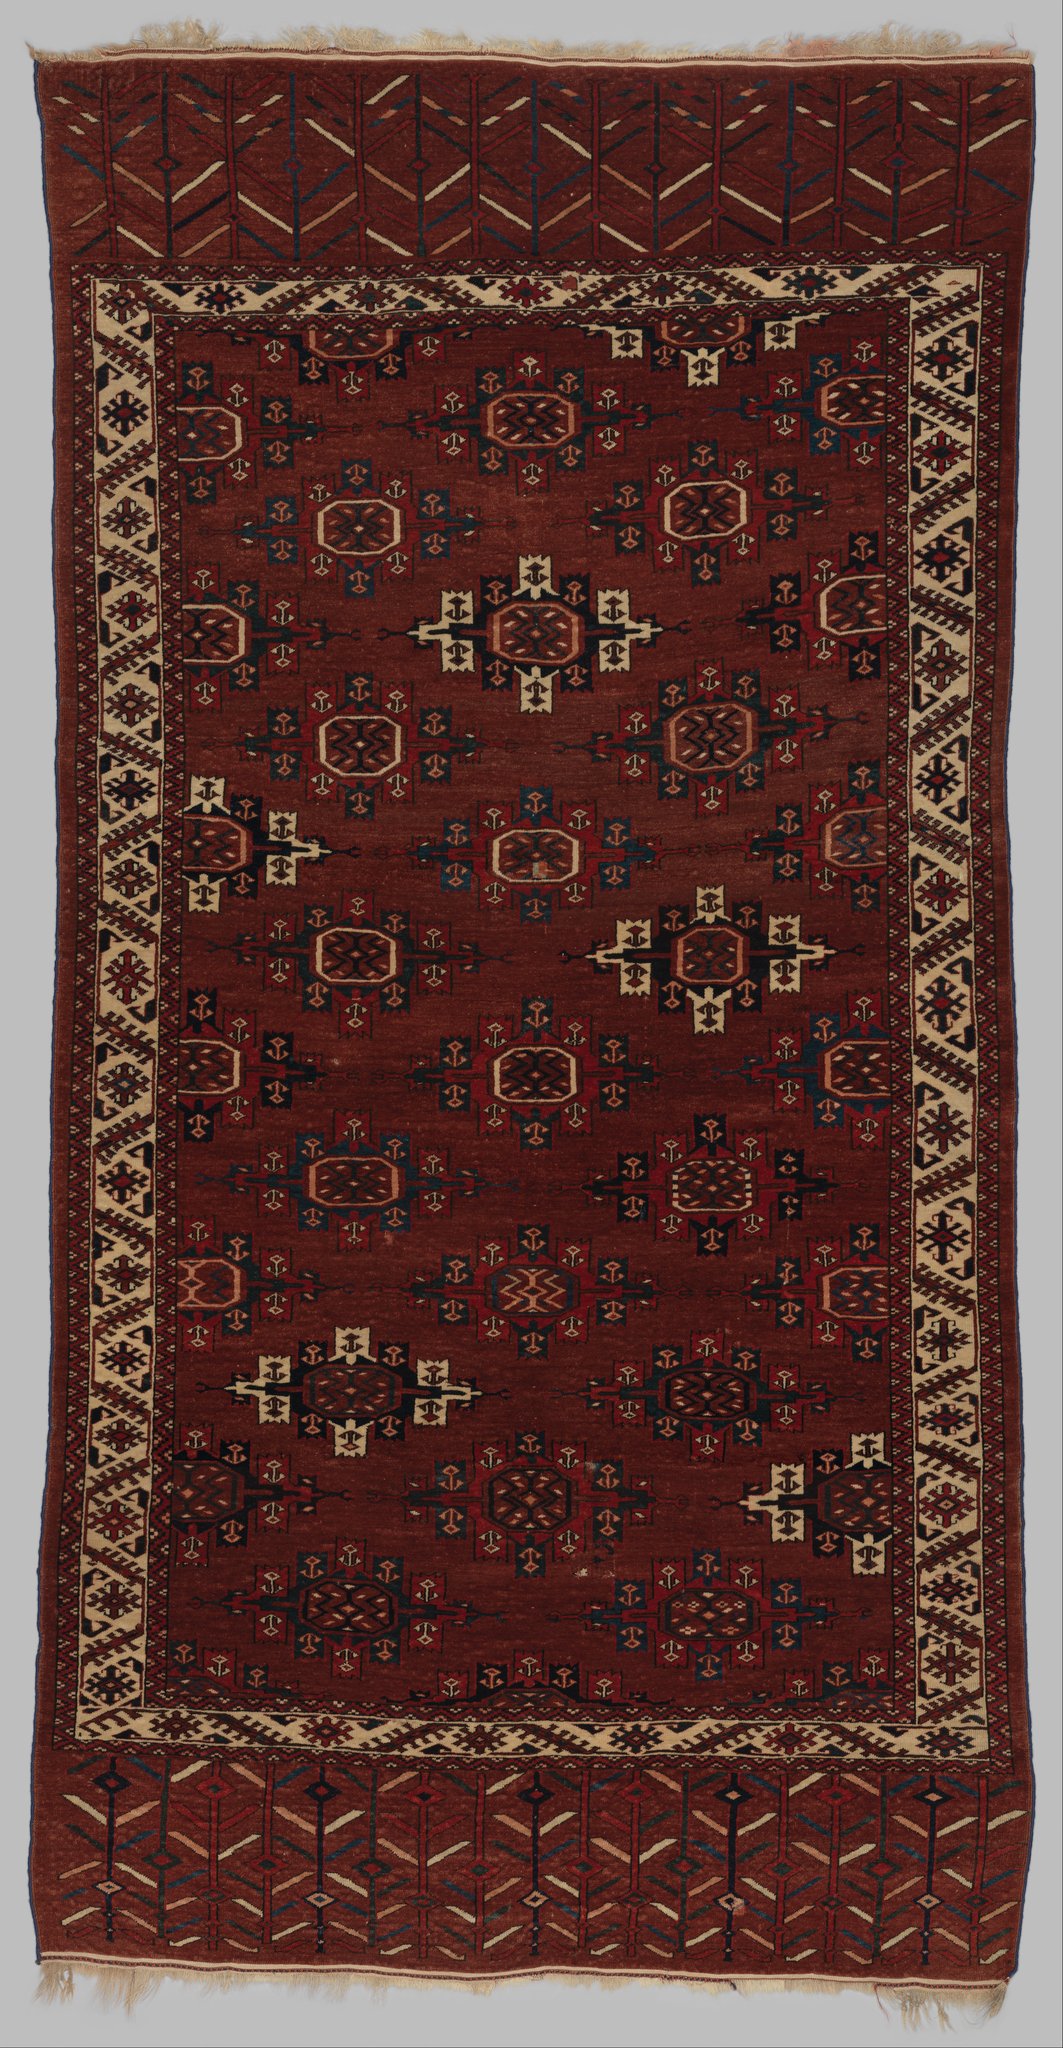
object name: carpet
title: Yomut Main Carpet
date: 1834-1866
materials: wool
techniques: pile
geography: western turkmenistan